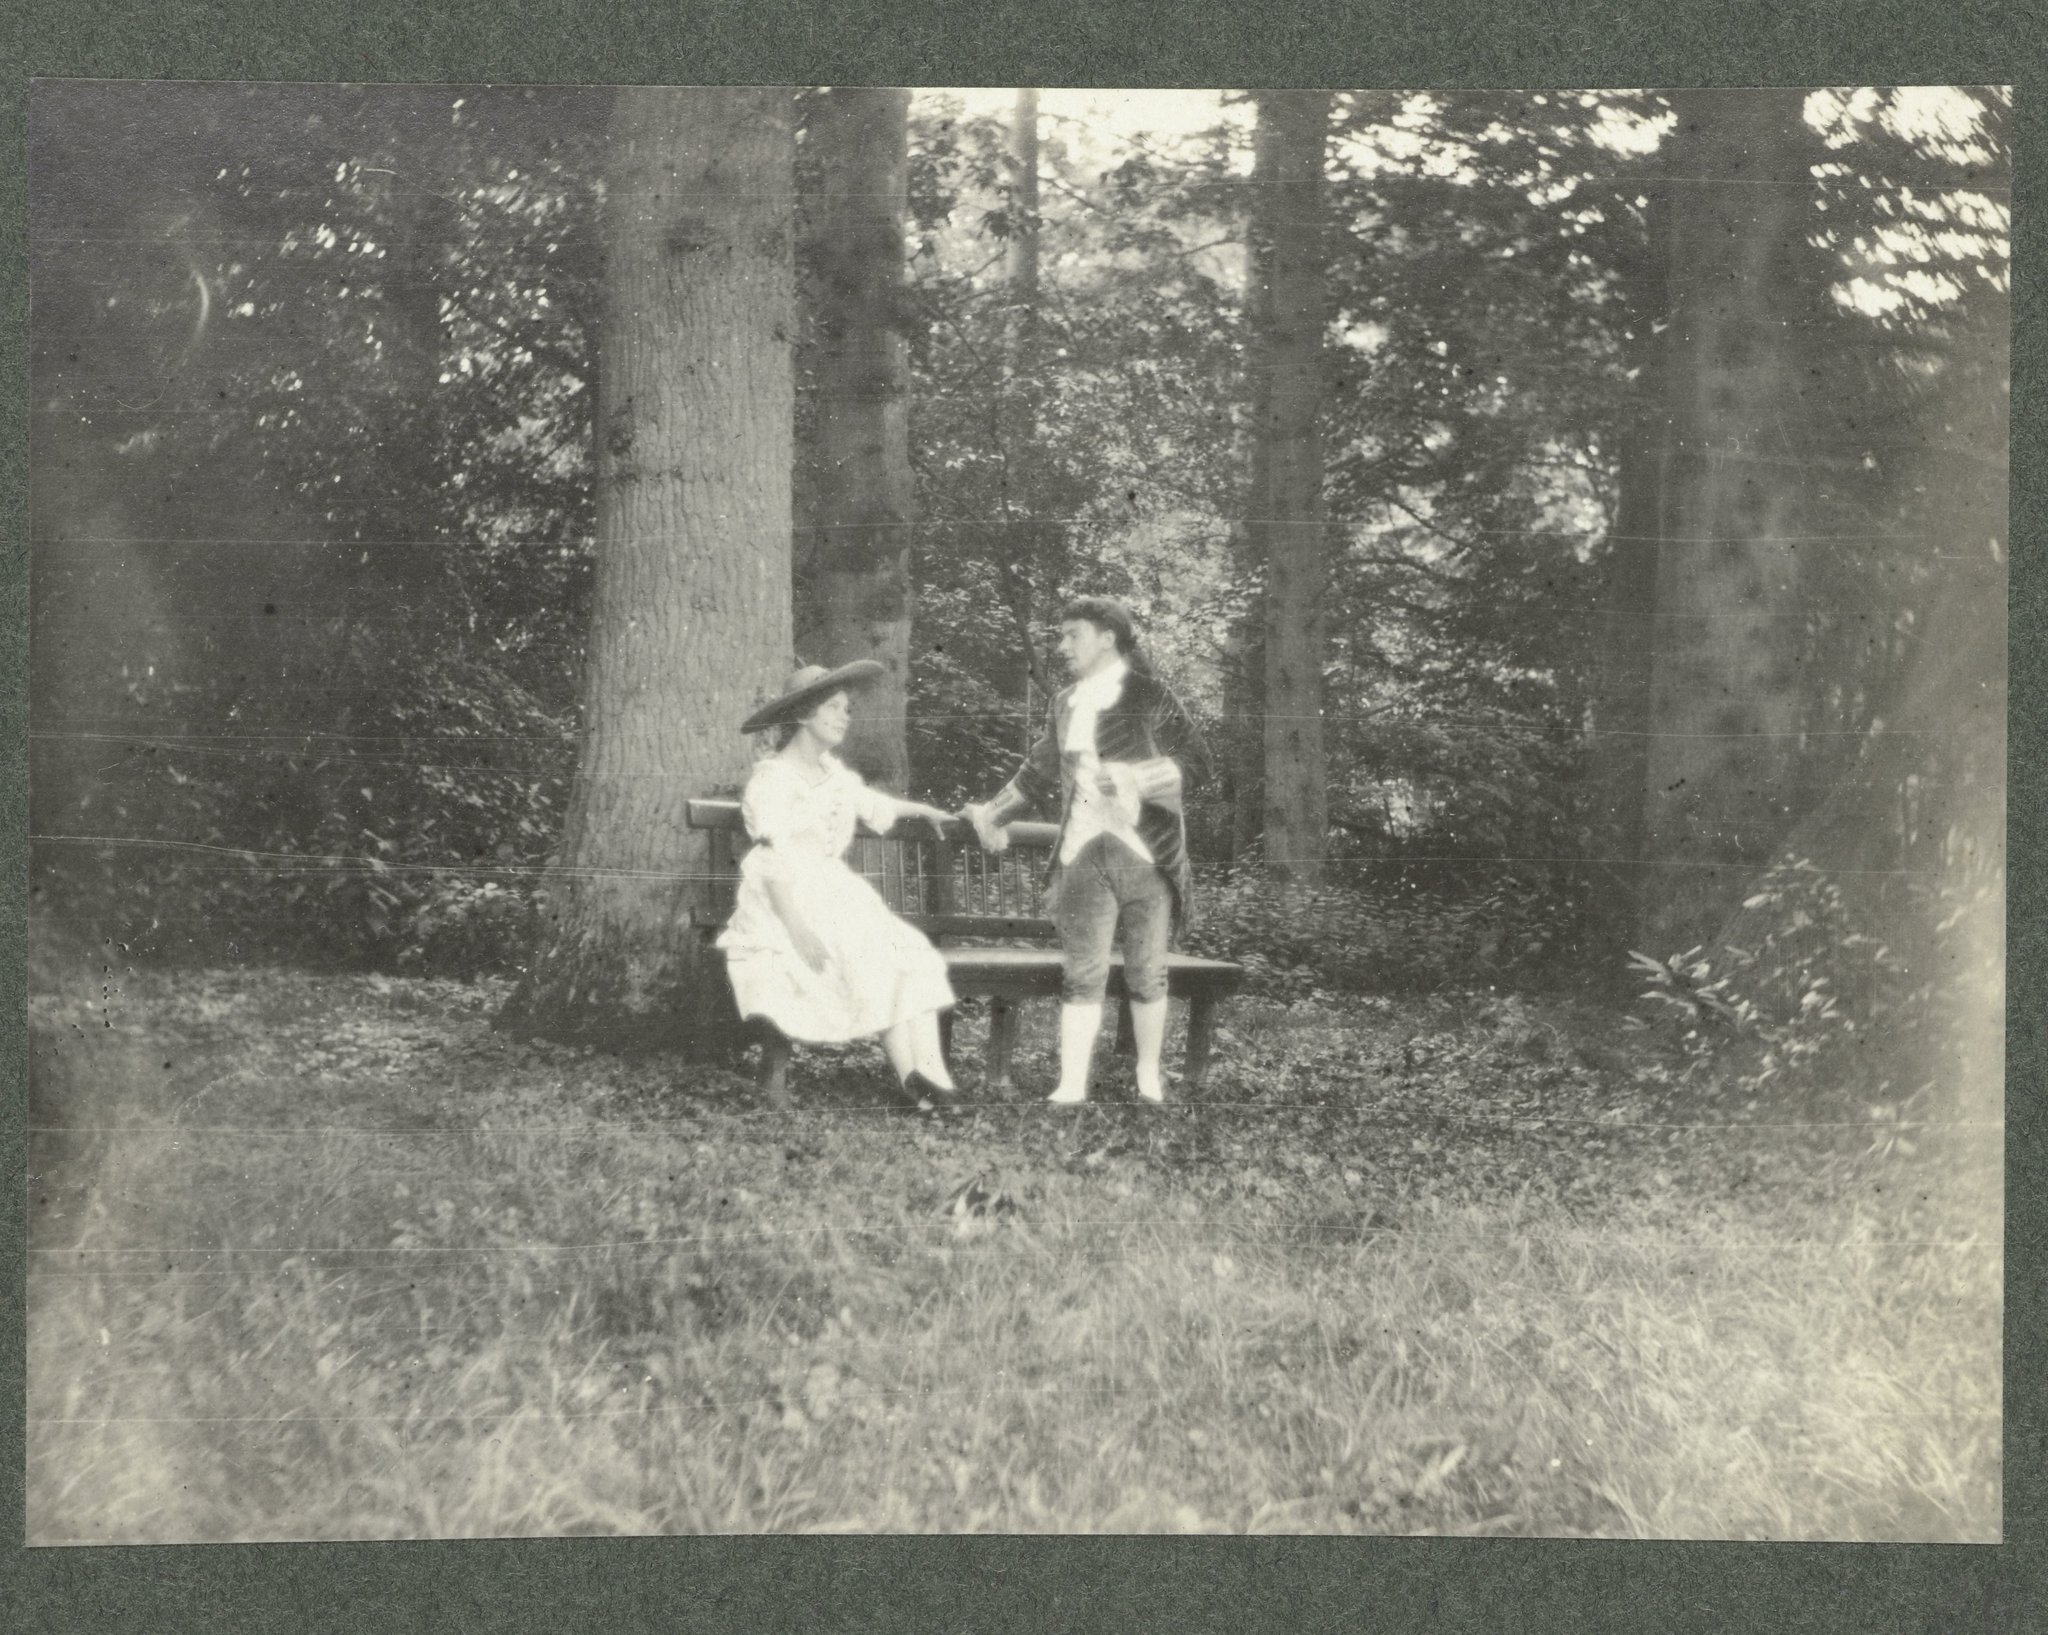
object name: photograph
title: Twee gekostumeerde mensen tijdens een opvoering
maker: geldolph adriaan kessler (dolph)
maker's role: fotograaf, industrieel, voetballer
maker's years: 1884-1945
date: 1913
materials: paper, photographic support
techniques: photography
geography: netherlands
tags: huize de paauw